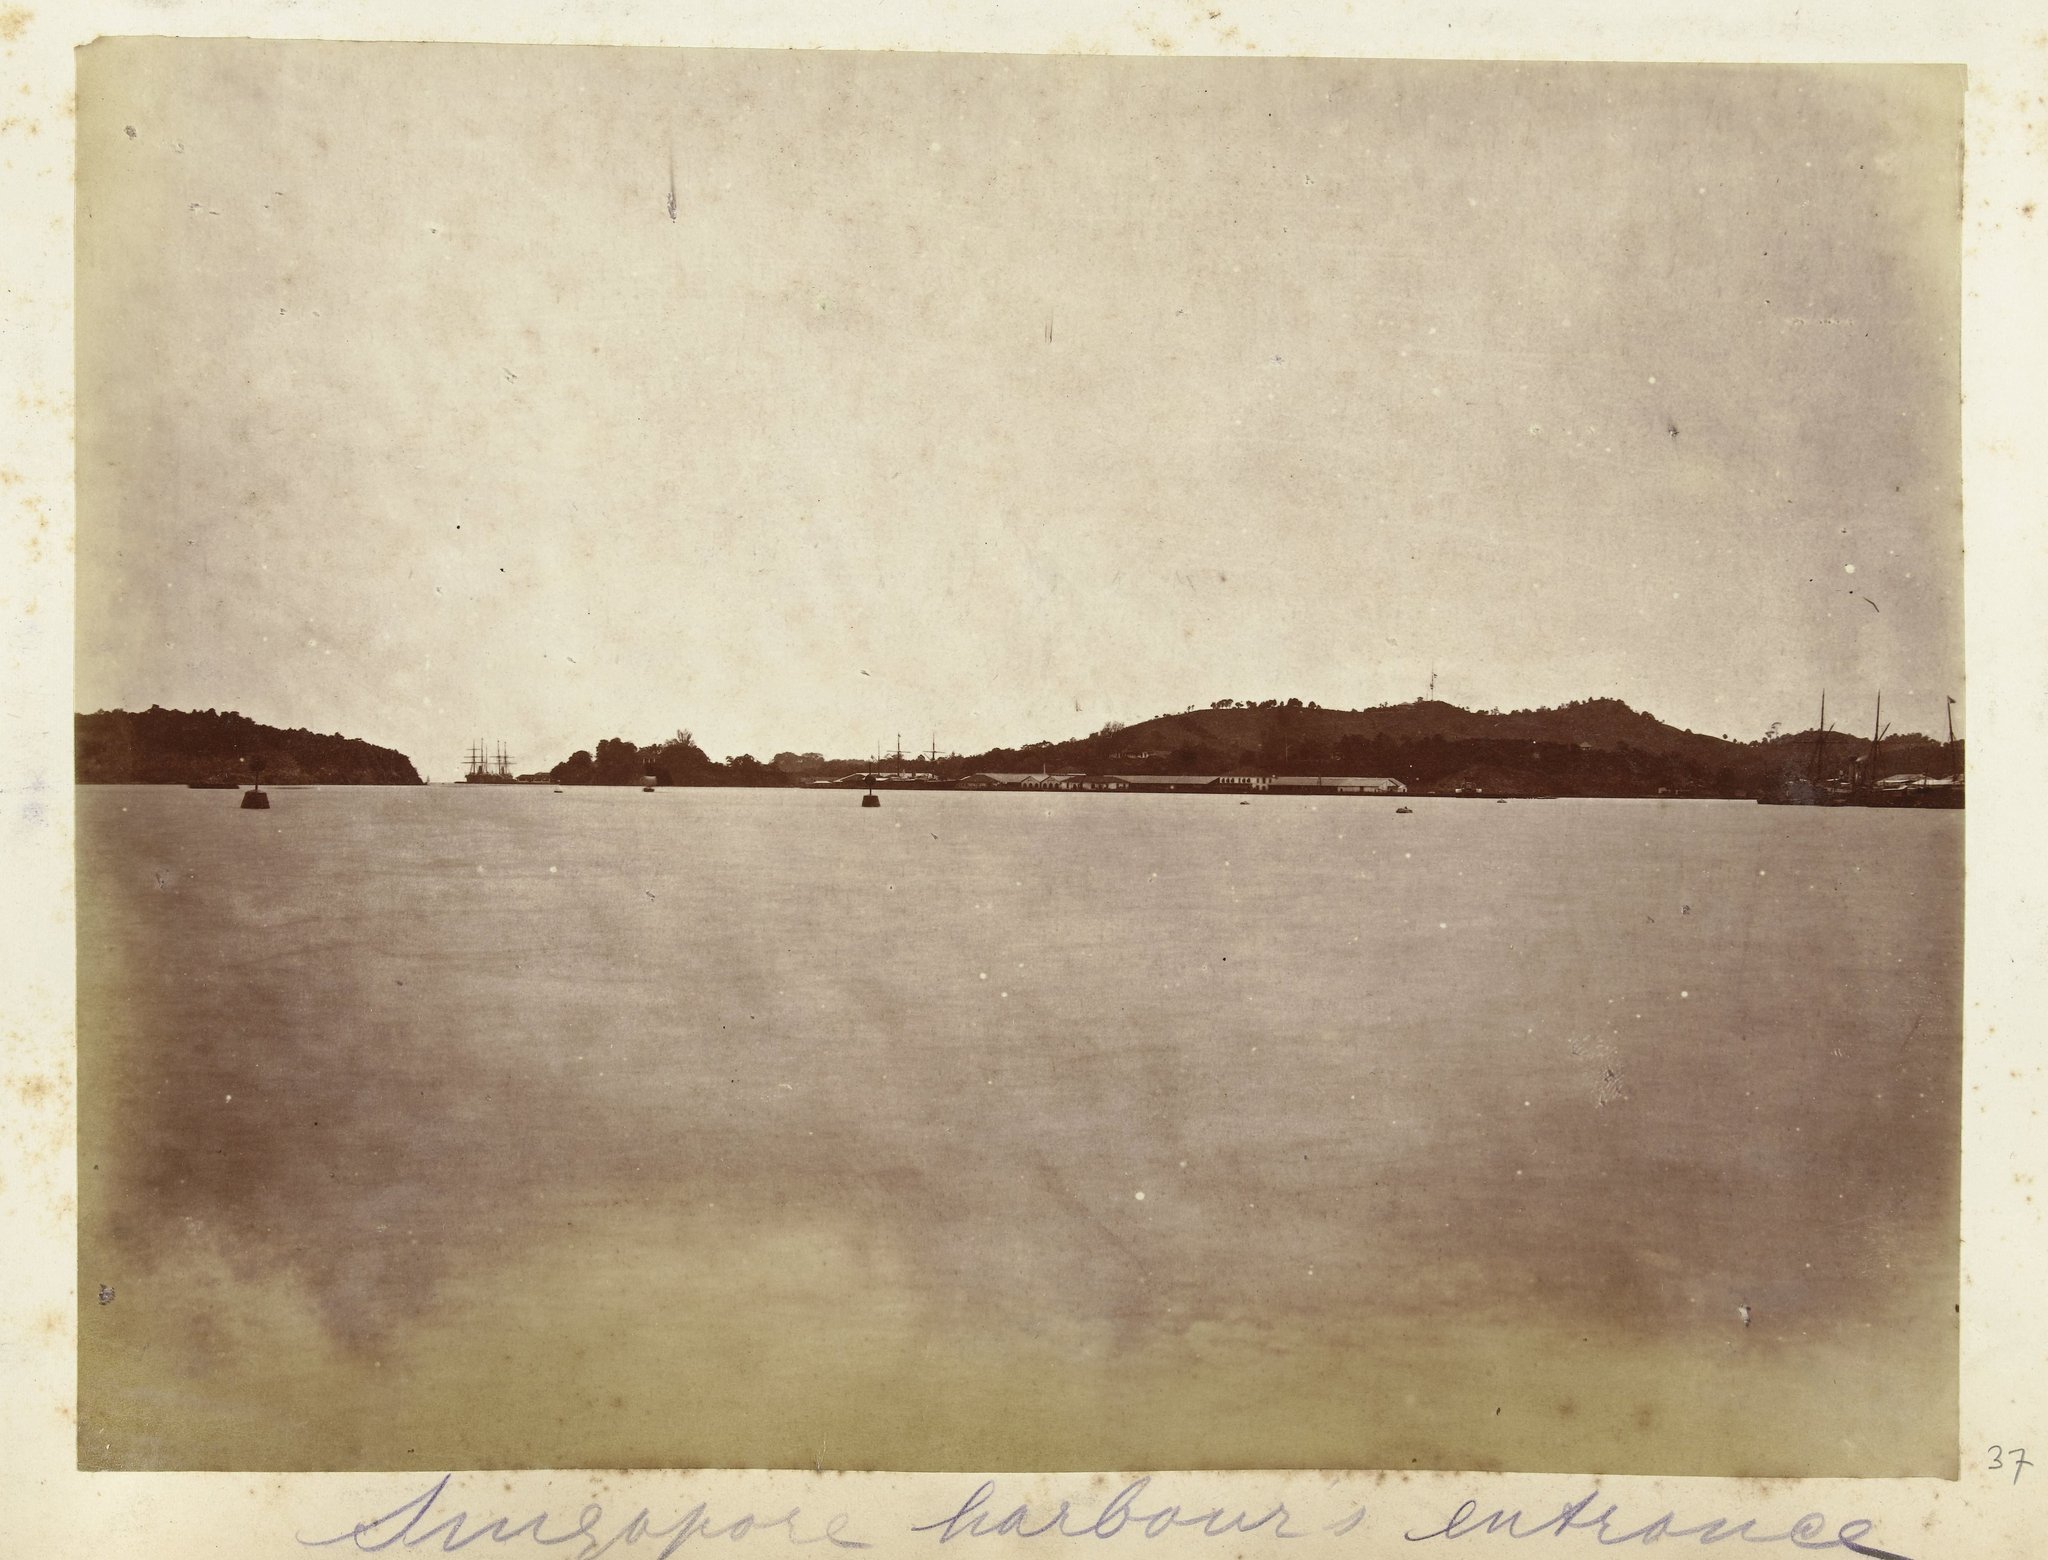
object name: photograph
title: Haven van Singapore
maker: Anonymous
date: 1890-1910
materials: cardboard, paper, photographic support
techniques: gelatin silver print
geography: netherlands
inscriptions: caption: ‘Singapore harbours entrance’